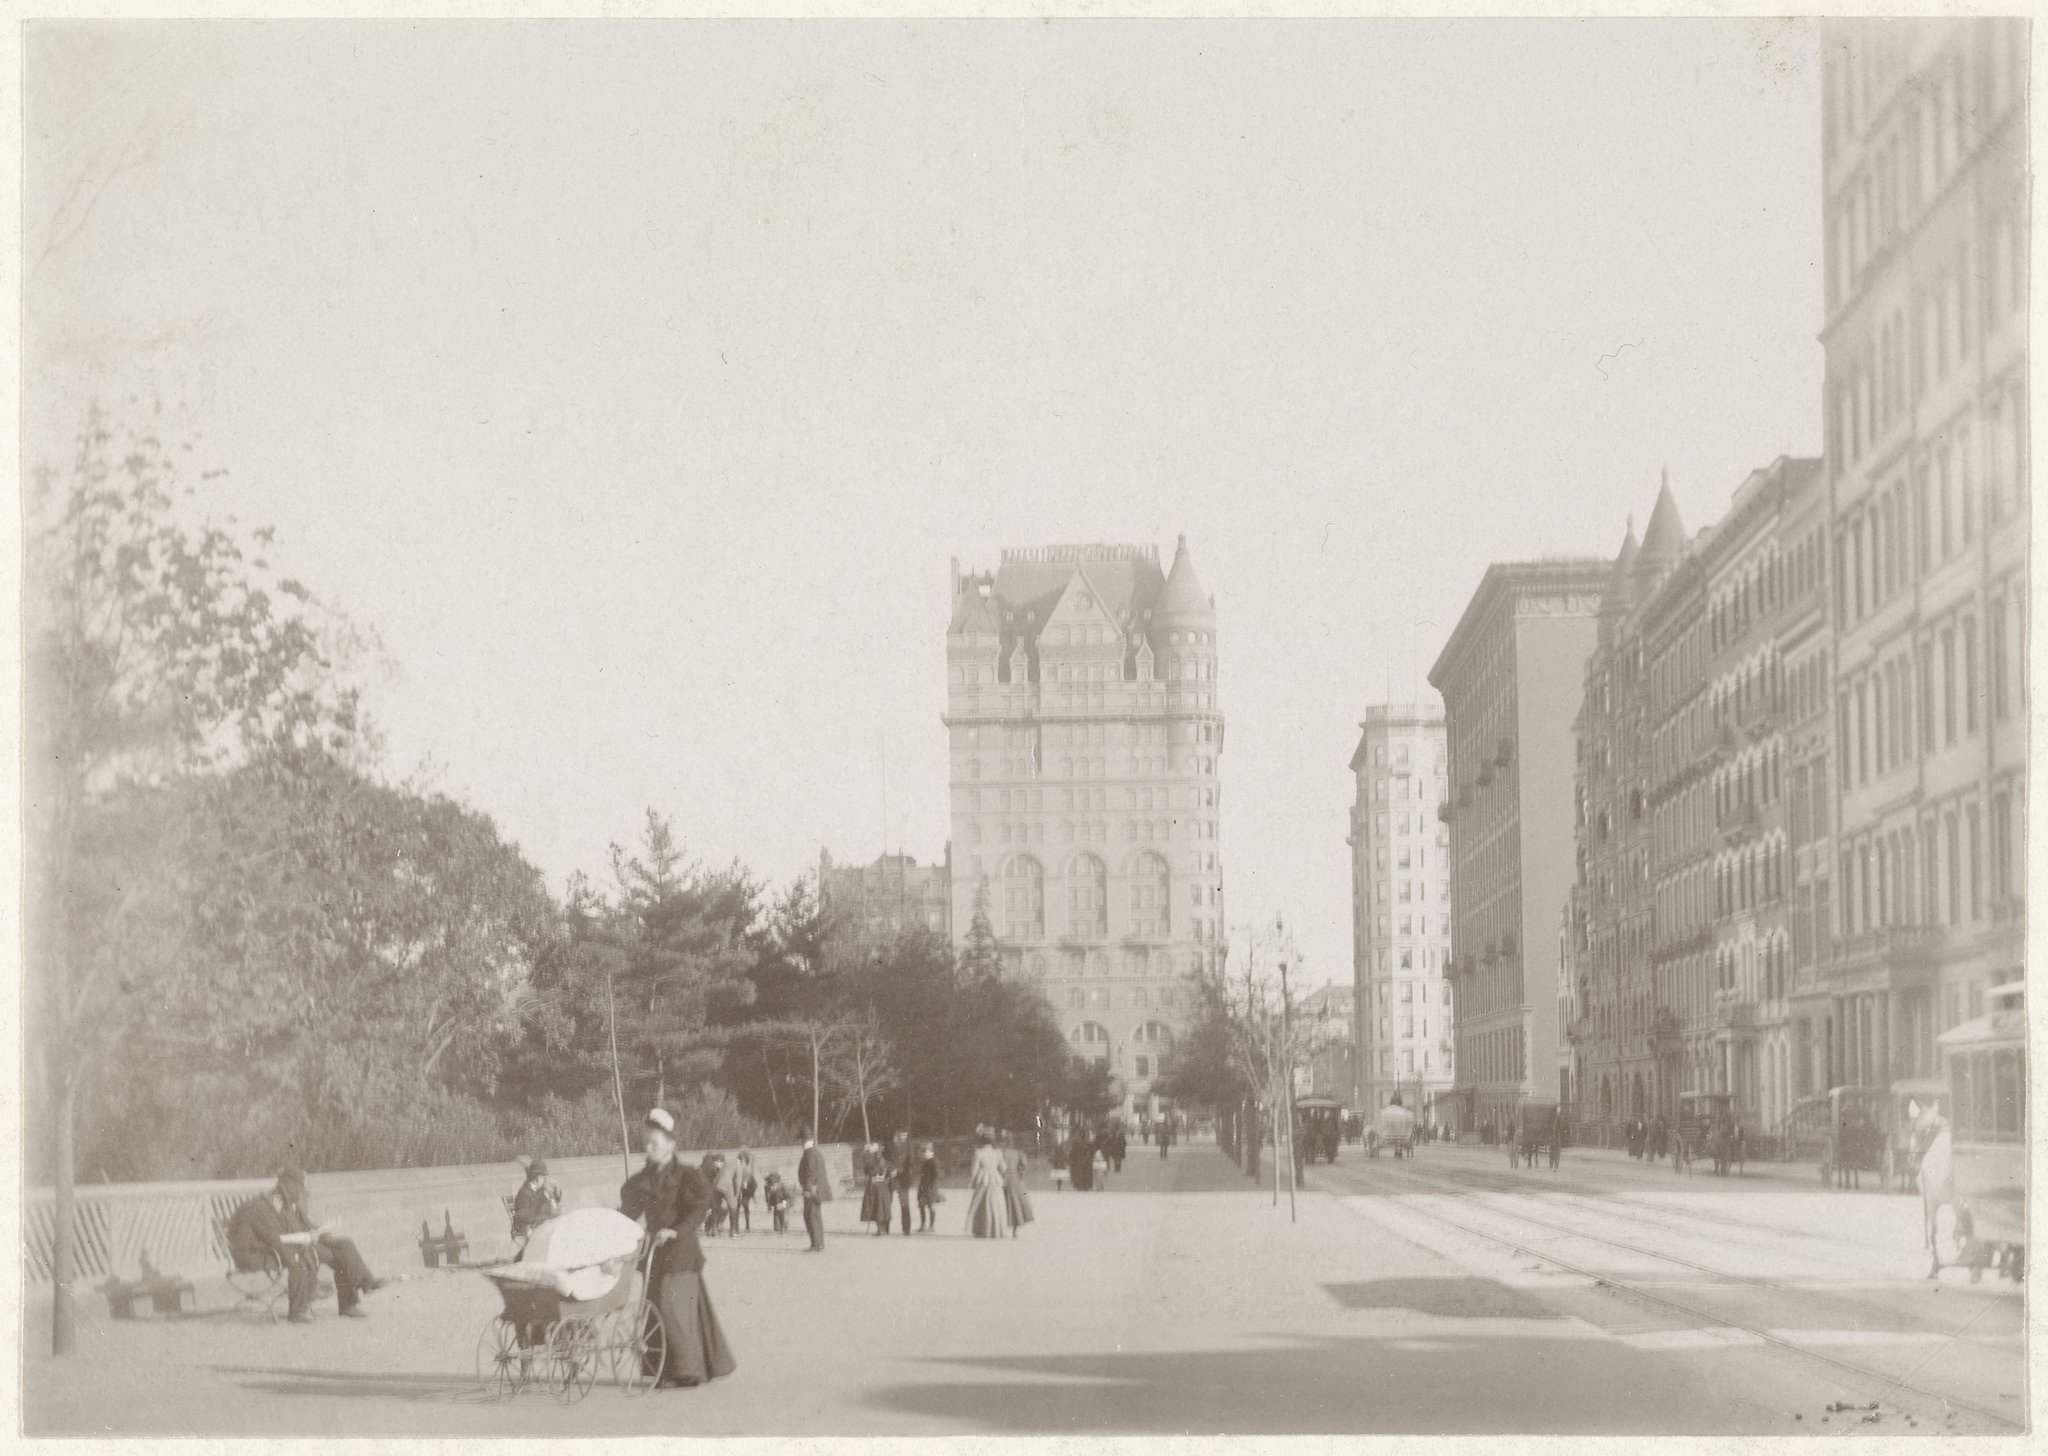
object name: photograph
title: Gezicht op 59th Street in New York, in de verte Hotel New Netherland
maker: Anonymous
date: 1893-1927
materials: paper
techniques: collodion silver print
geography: new york city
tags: street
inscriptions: inscription: ‘In de 59e straat’